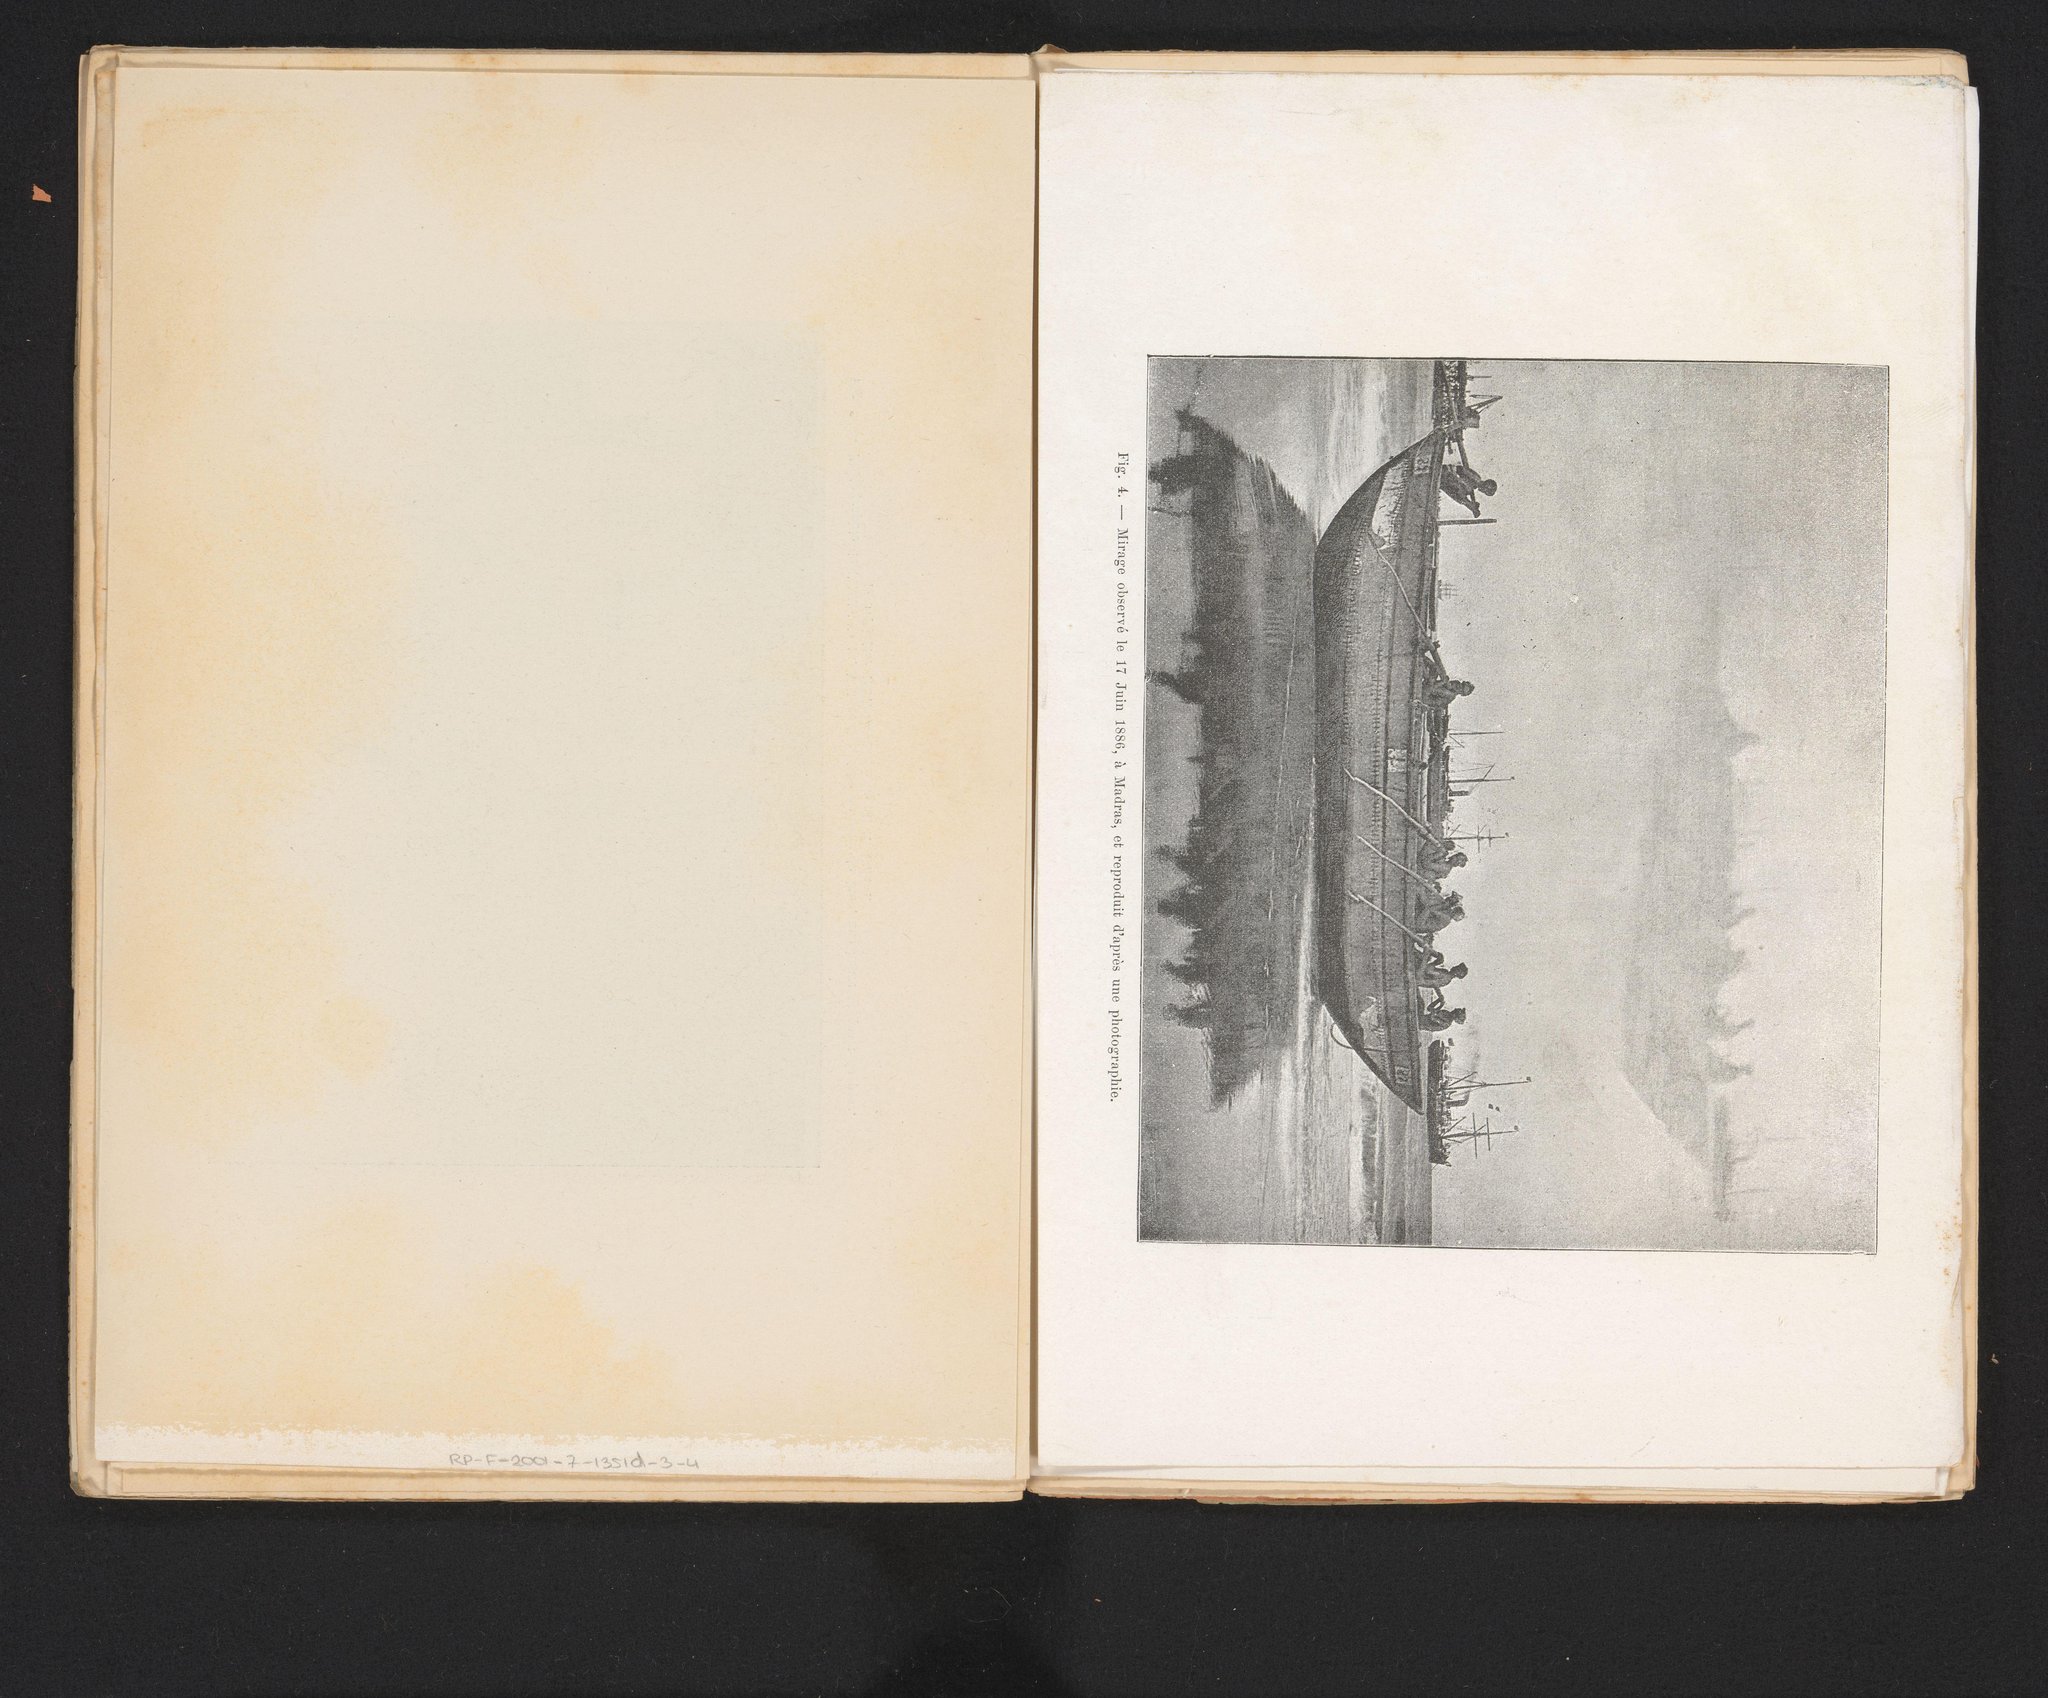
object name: page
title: Mannen in een roeiboot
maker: Anonymous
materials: paper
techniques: autotype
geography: chennai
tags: rowing facing backward, pulling (+ four persons or more ~ traffic and transport)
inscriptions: inscription: ‘Fig. 4. - Mirage observé le 17 Juin 1886, à Madras, et reproduit d'après une photographie.’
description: Prent op plaat los in boek tussen pagina 134 en 135.